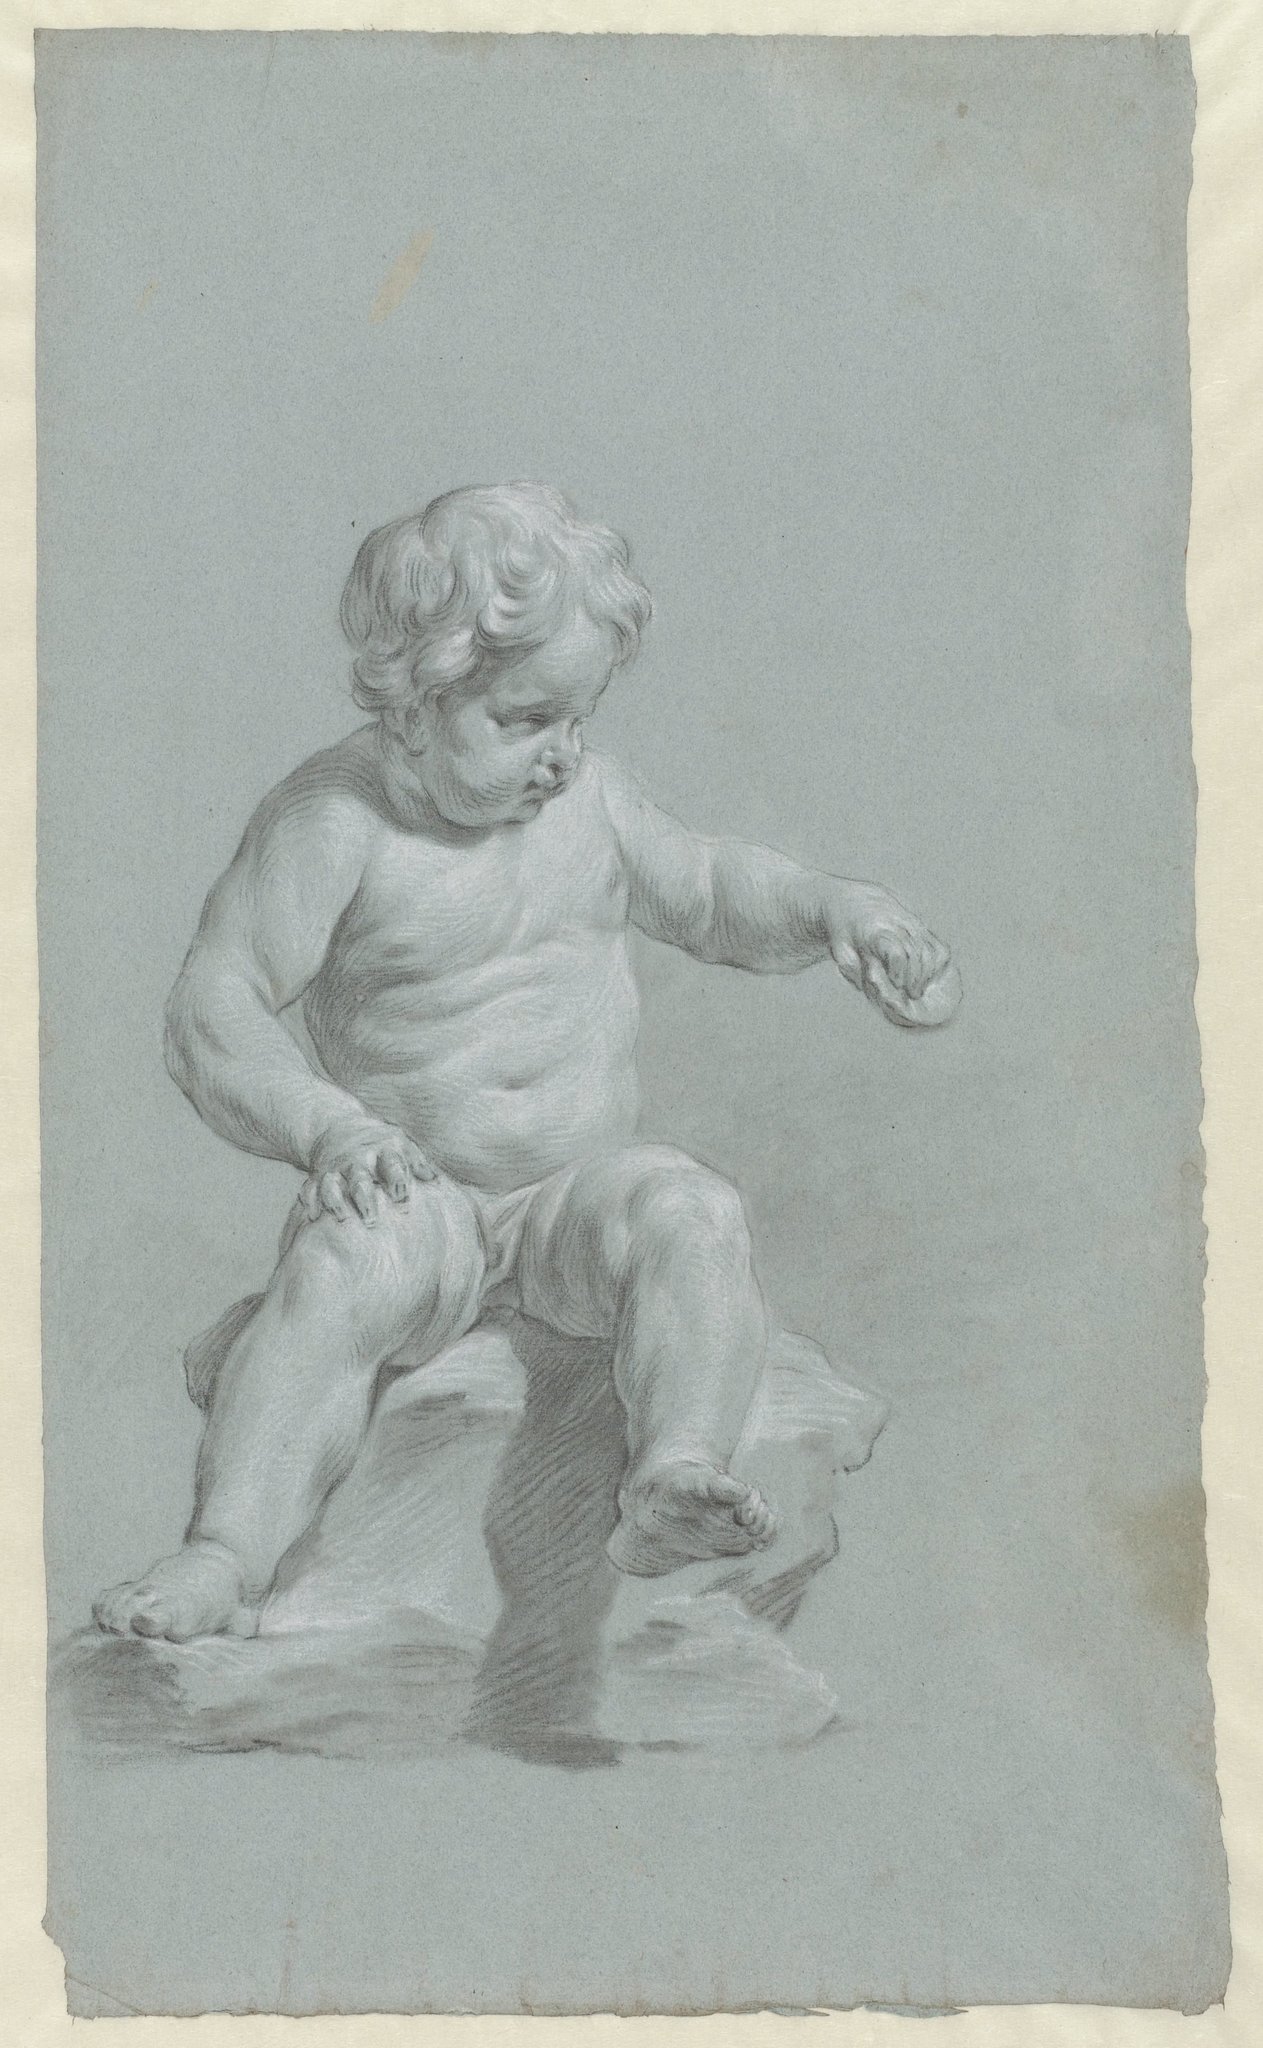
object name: drawing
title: Pleisterstudie van een zittend naakt kind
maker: cornelis joseph d heur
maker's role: draughtsman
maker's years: 1707-1762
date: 1717-1762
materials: chalk, paper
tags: piece of sculpture, reproduction of a piece of sculpture, child (+ sitting)